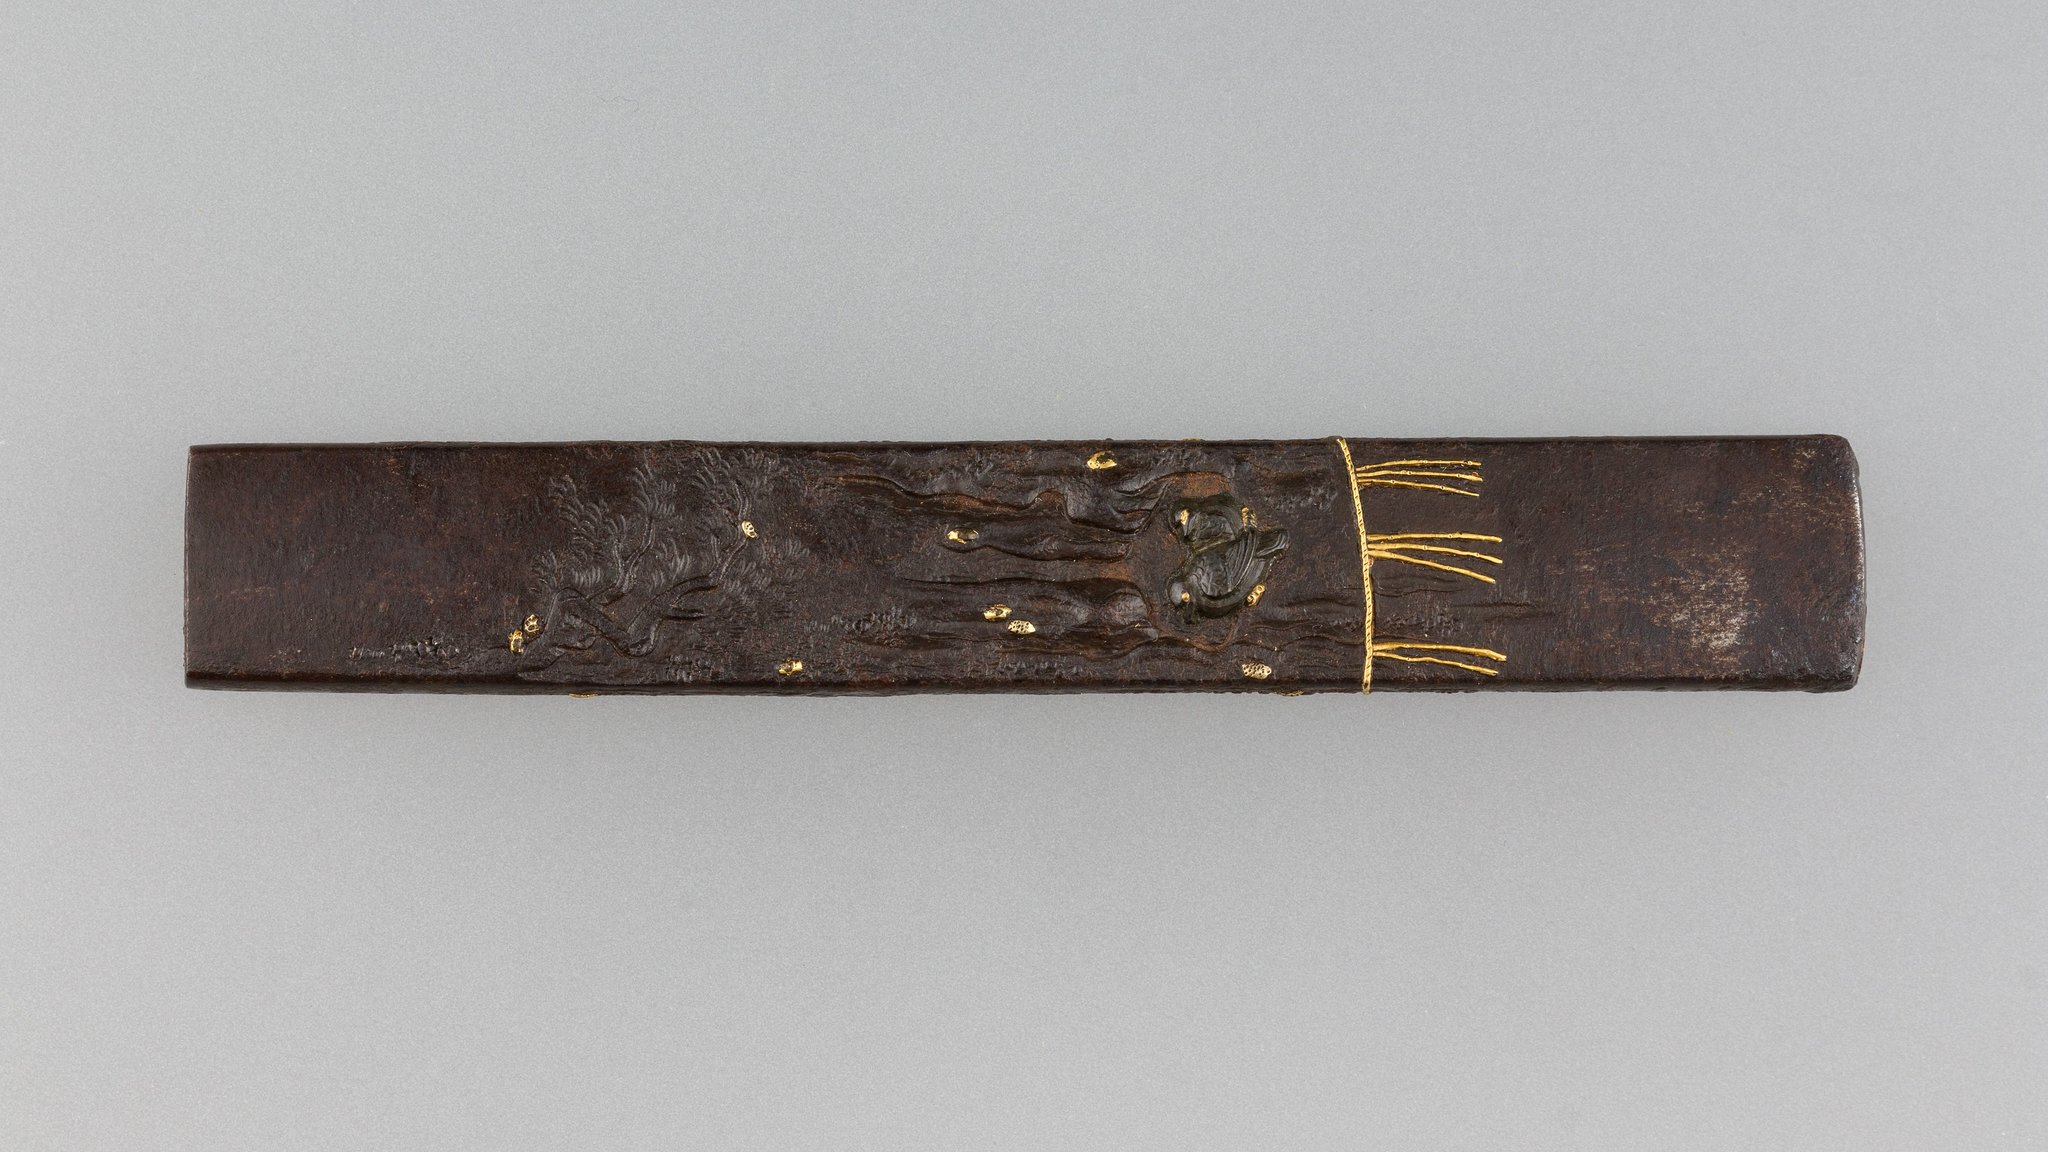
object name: knife handle kozuka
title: Knife Handle (Kozuka)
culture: japanese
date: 1801-1833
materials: gold, iron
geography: japan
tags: birds,trees